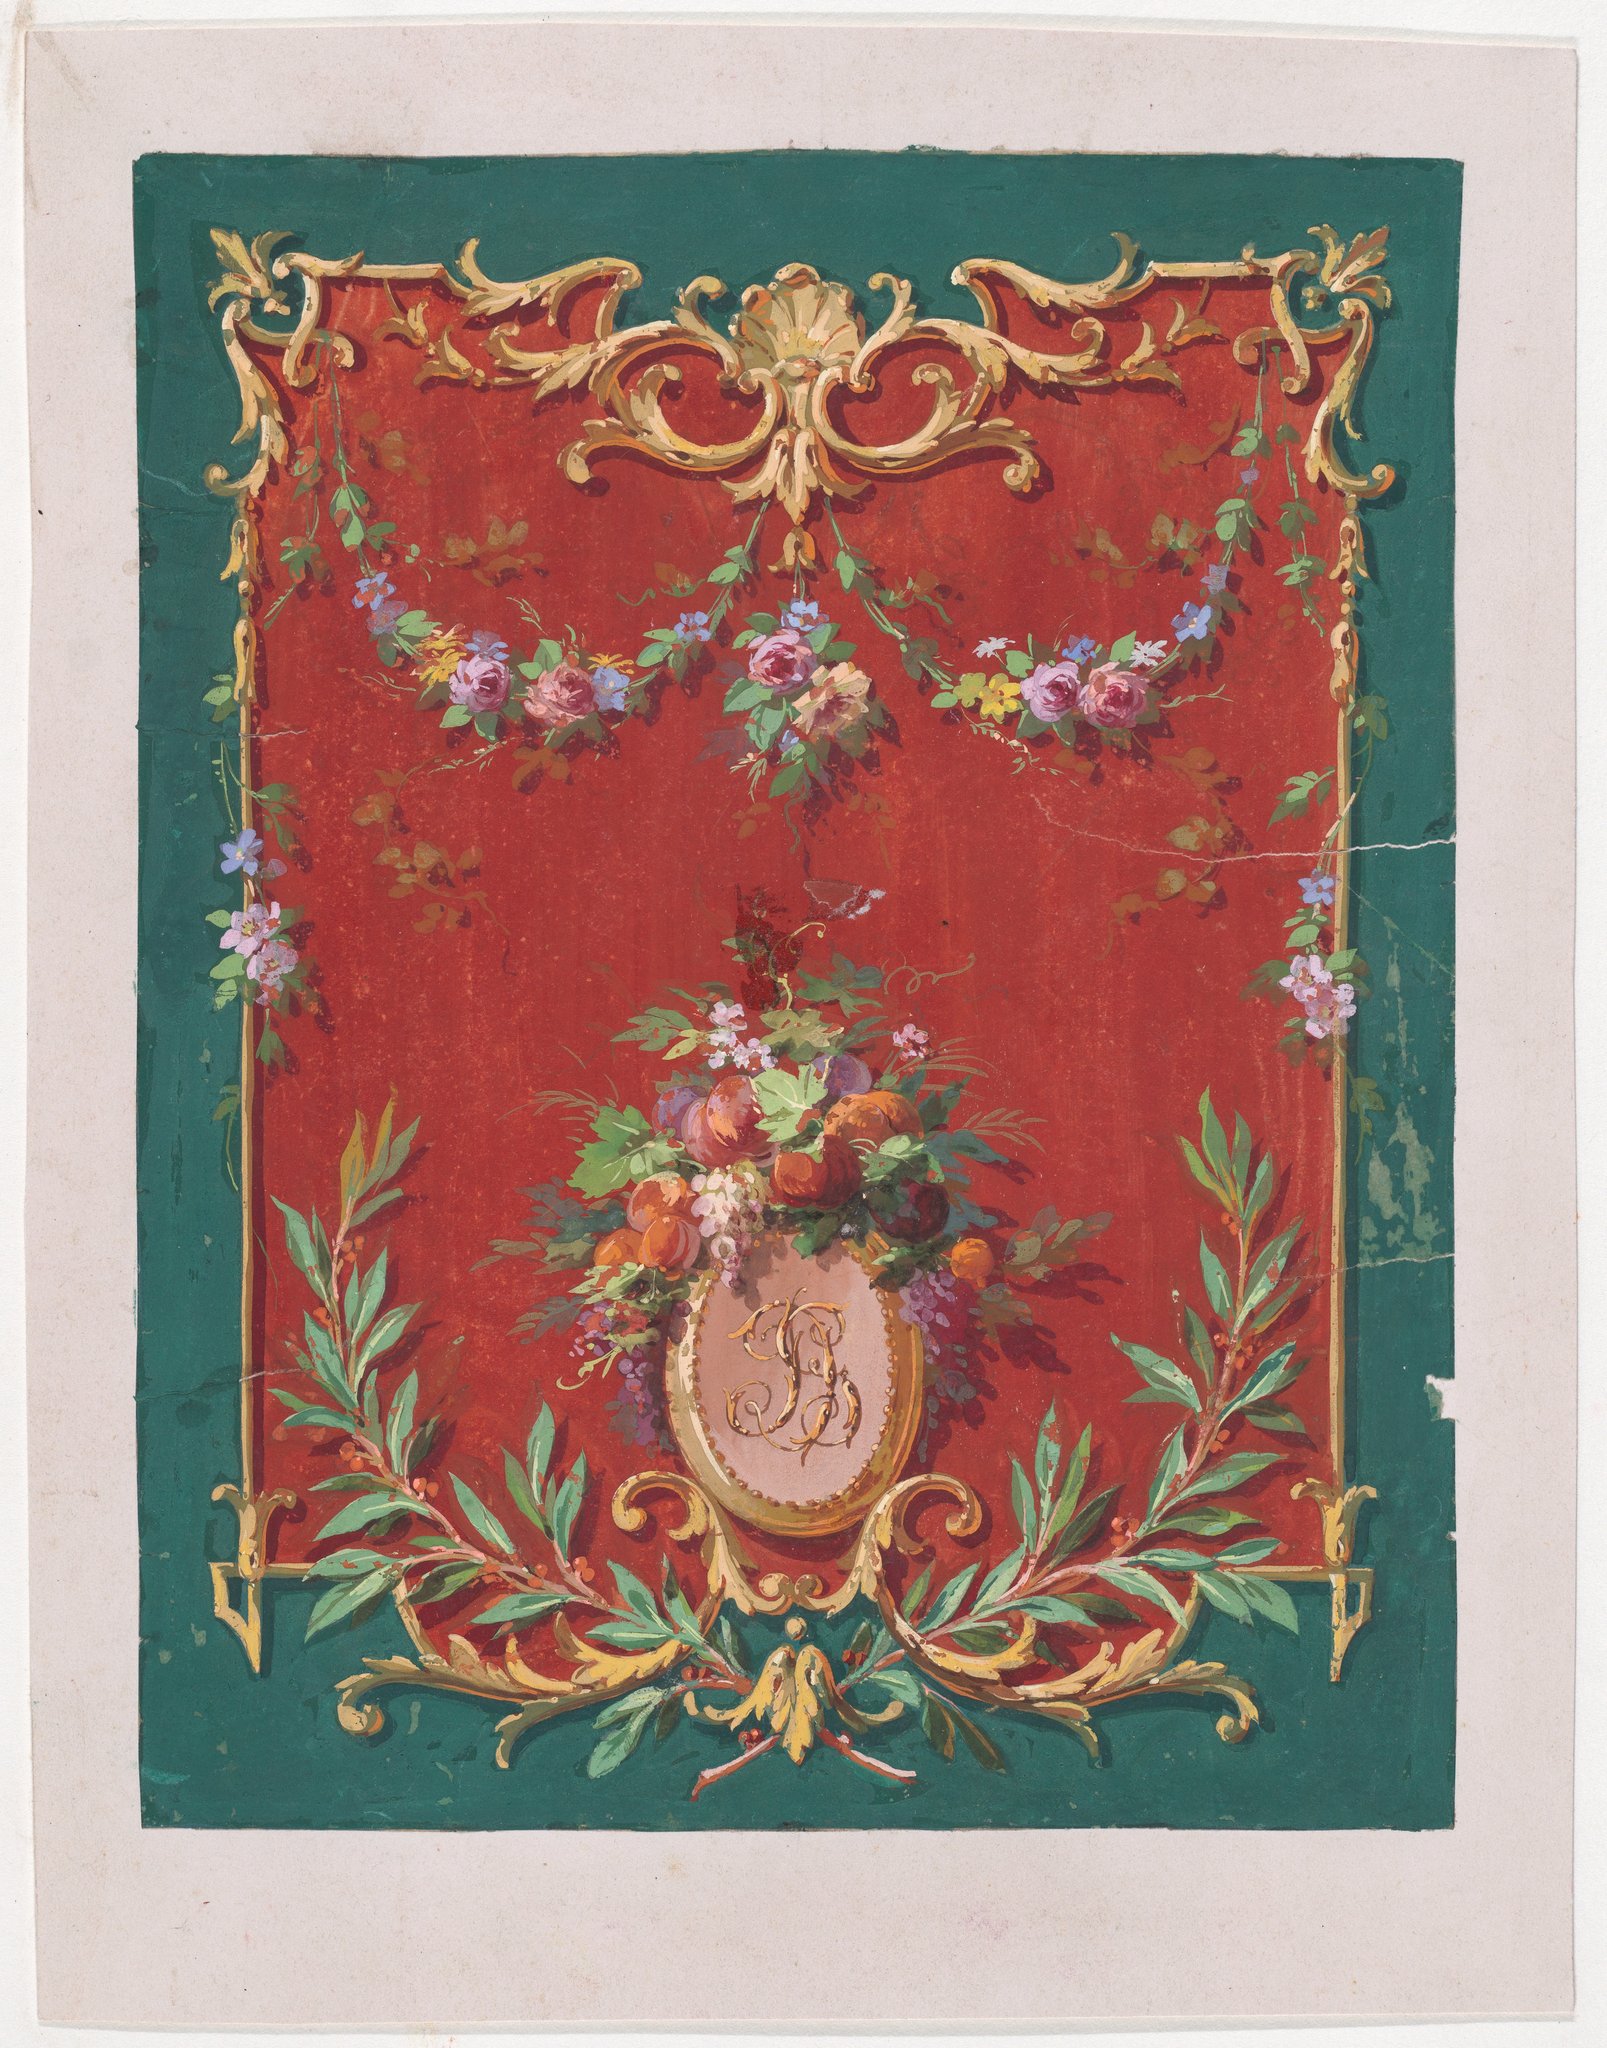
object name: drawing ornament architecture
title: Design for a Panel or Wallpaper (?) with an Ornamental Frame with Scrolls and a Shell Decorated with Garlands and Bundles of Flowers and Fruits and a Monogrammed Oval Frame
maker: anonymous, french, 19th century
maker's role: designer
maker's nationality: french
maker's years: 1800-1900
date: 1870-1900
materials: watercolor